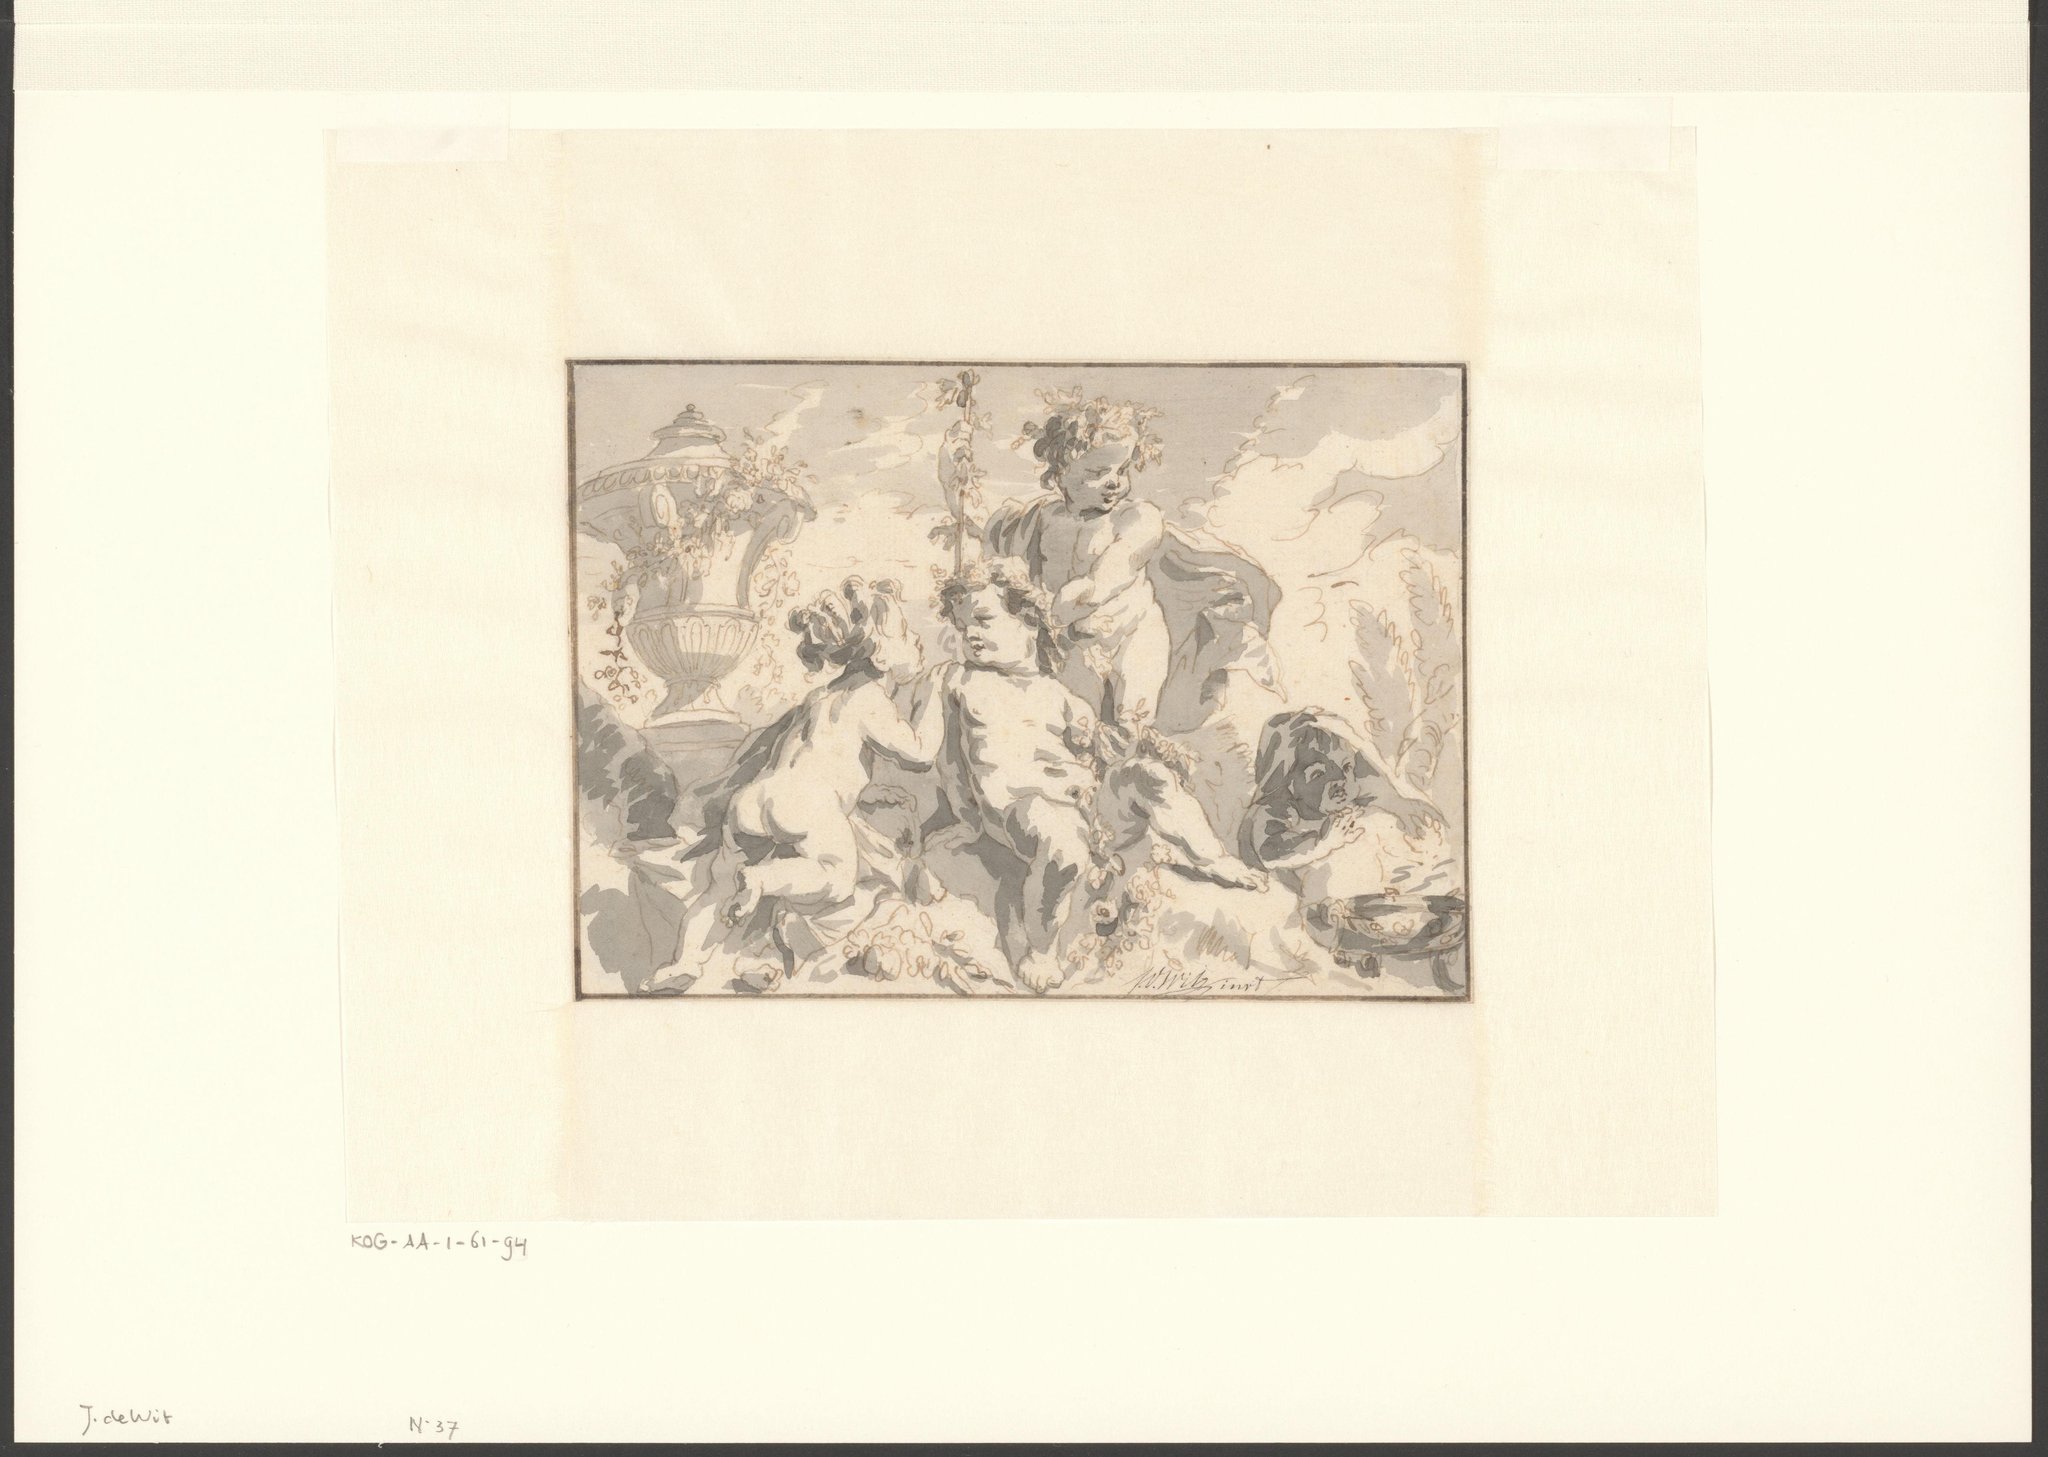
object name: drawing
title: Vier putti bij een siervaas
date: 1750-1799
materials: ink, paper, pencil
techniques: brush, pen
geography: amsterdam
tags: vase ~ ornament, cupids: 'amores', 'amoretti', 'putti'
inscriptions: signature: ‘J.d.Wit invt’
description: Onderwerpsrubriek binnen de Atlas Amsterdam: Teekenacademie - Kon. Academie van Beeldende Kunsten - Schildersateliers.